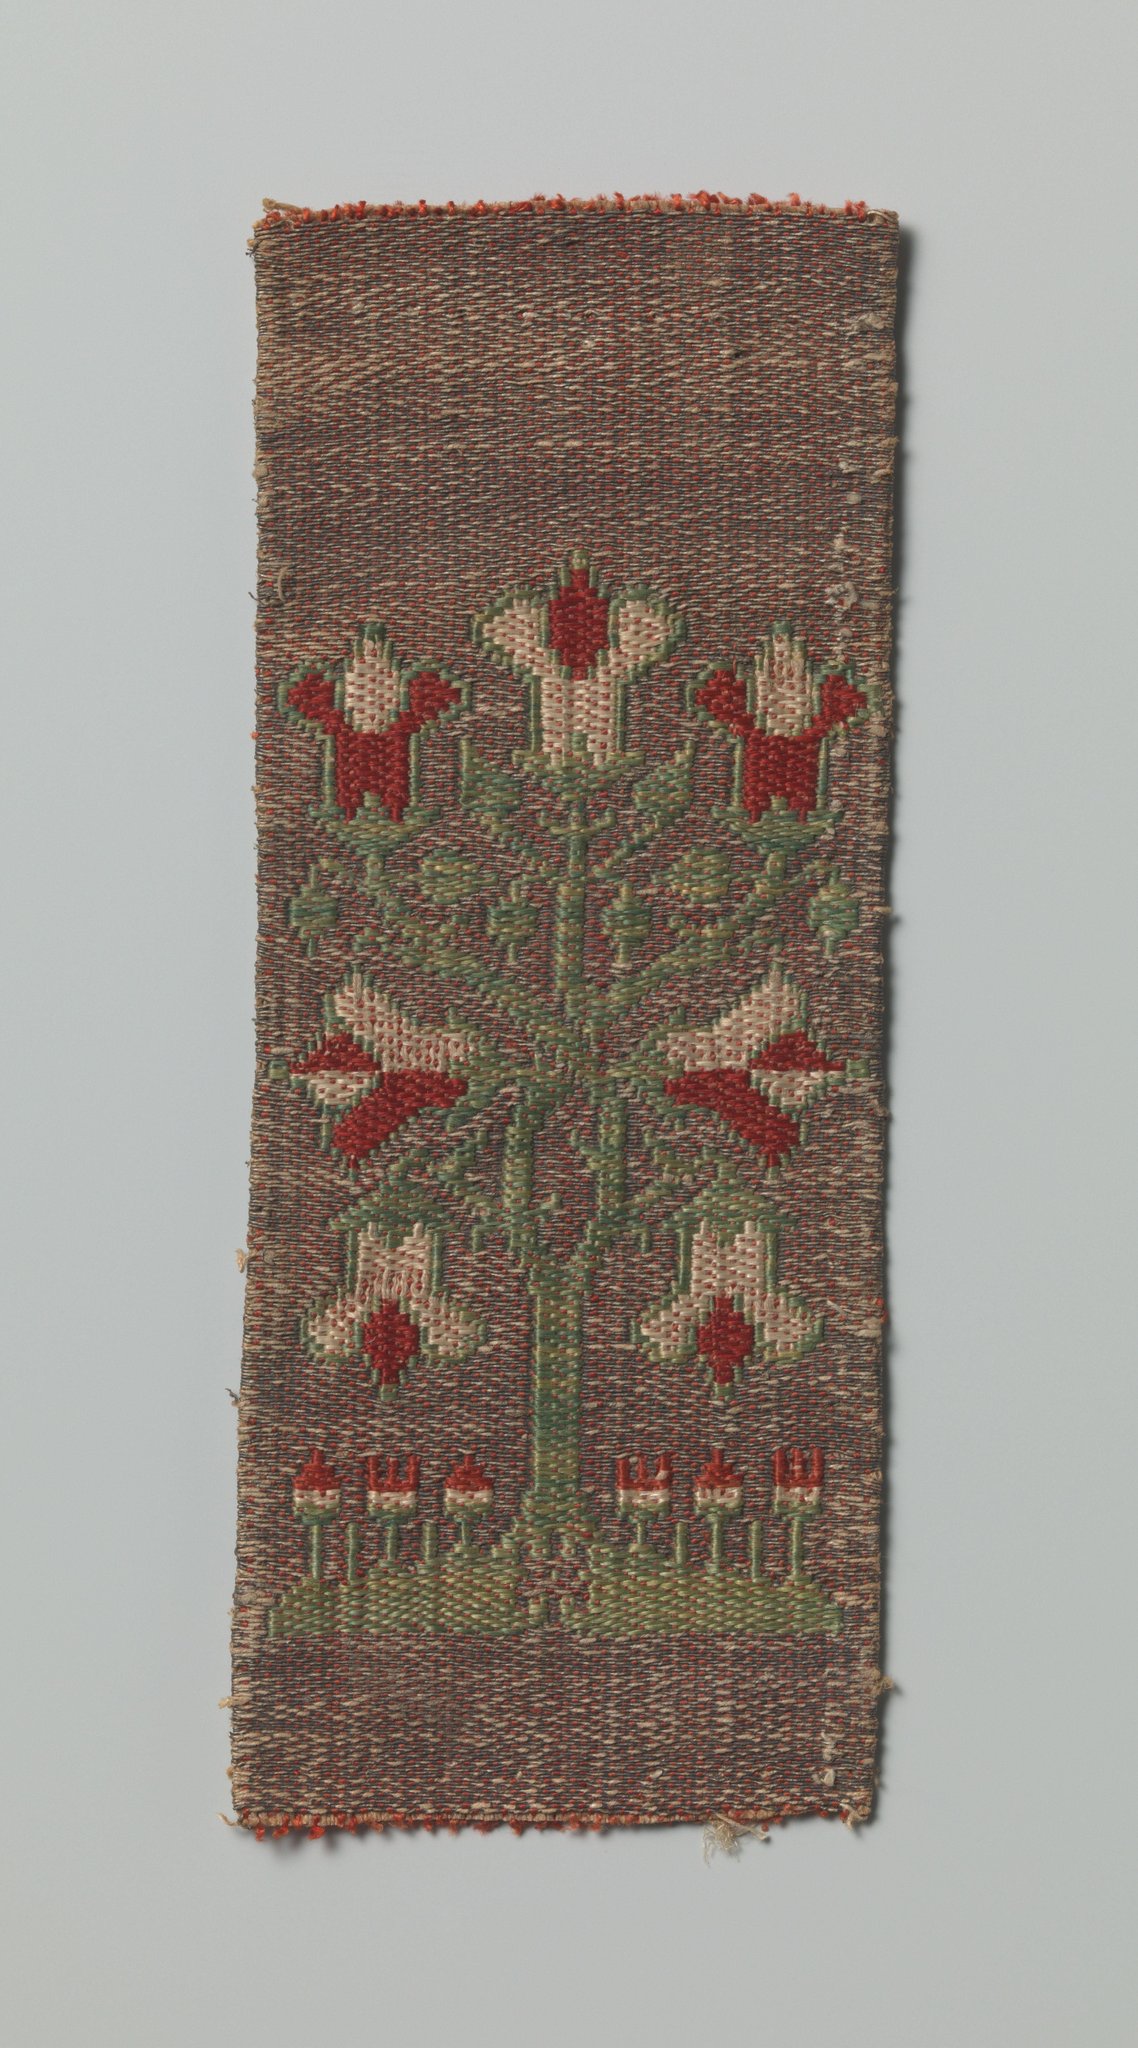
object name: band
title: Fragment Keuls bandweefsel (orfroi) met patroon van een gestileerde boom met kegelvormige bloemen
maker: Anonymous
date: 1499-1700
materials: textile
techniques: weave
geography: germany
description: Fragment Keuls bandweefsel (orfroi) met een patroon van een gestileerde boom met kegelvormige bloemen. De boom staat op een bloeiend veld.